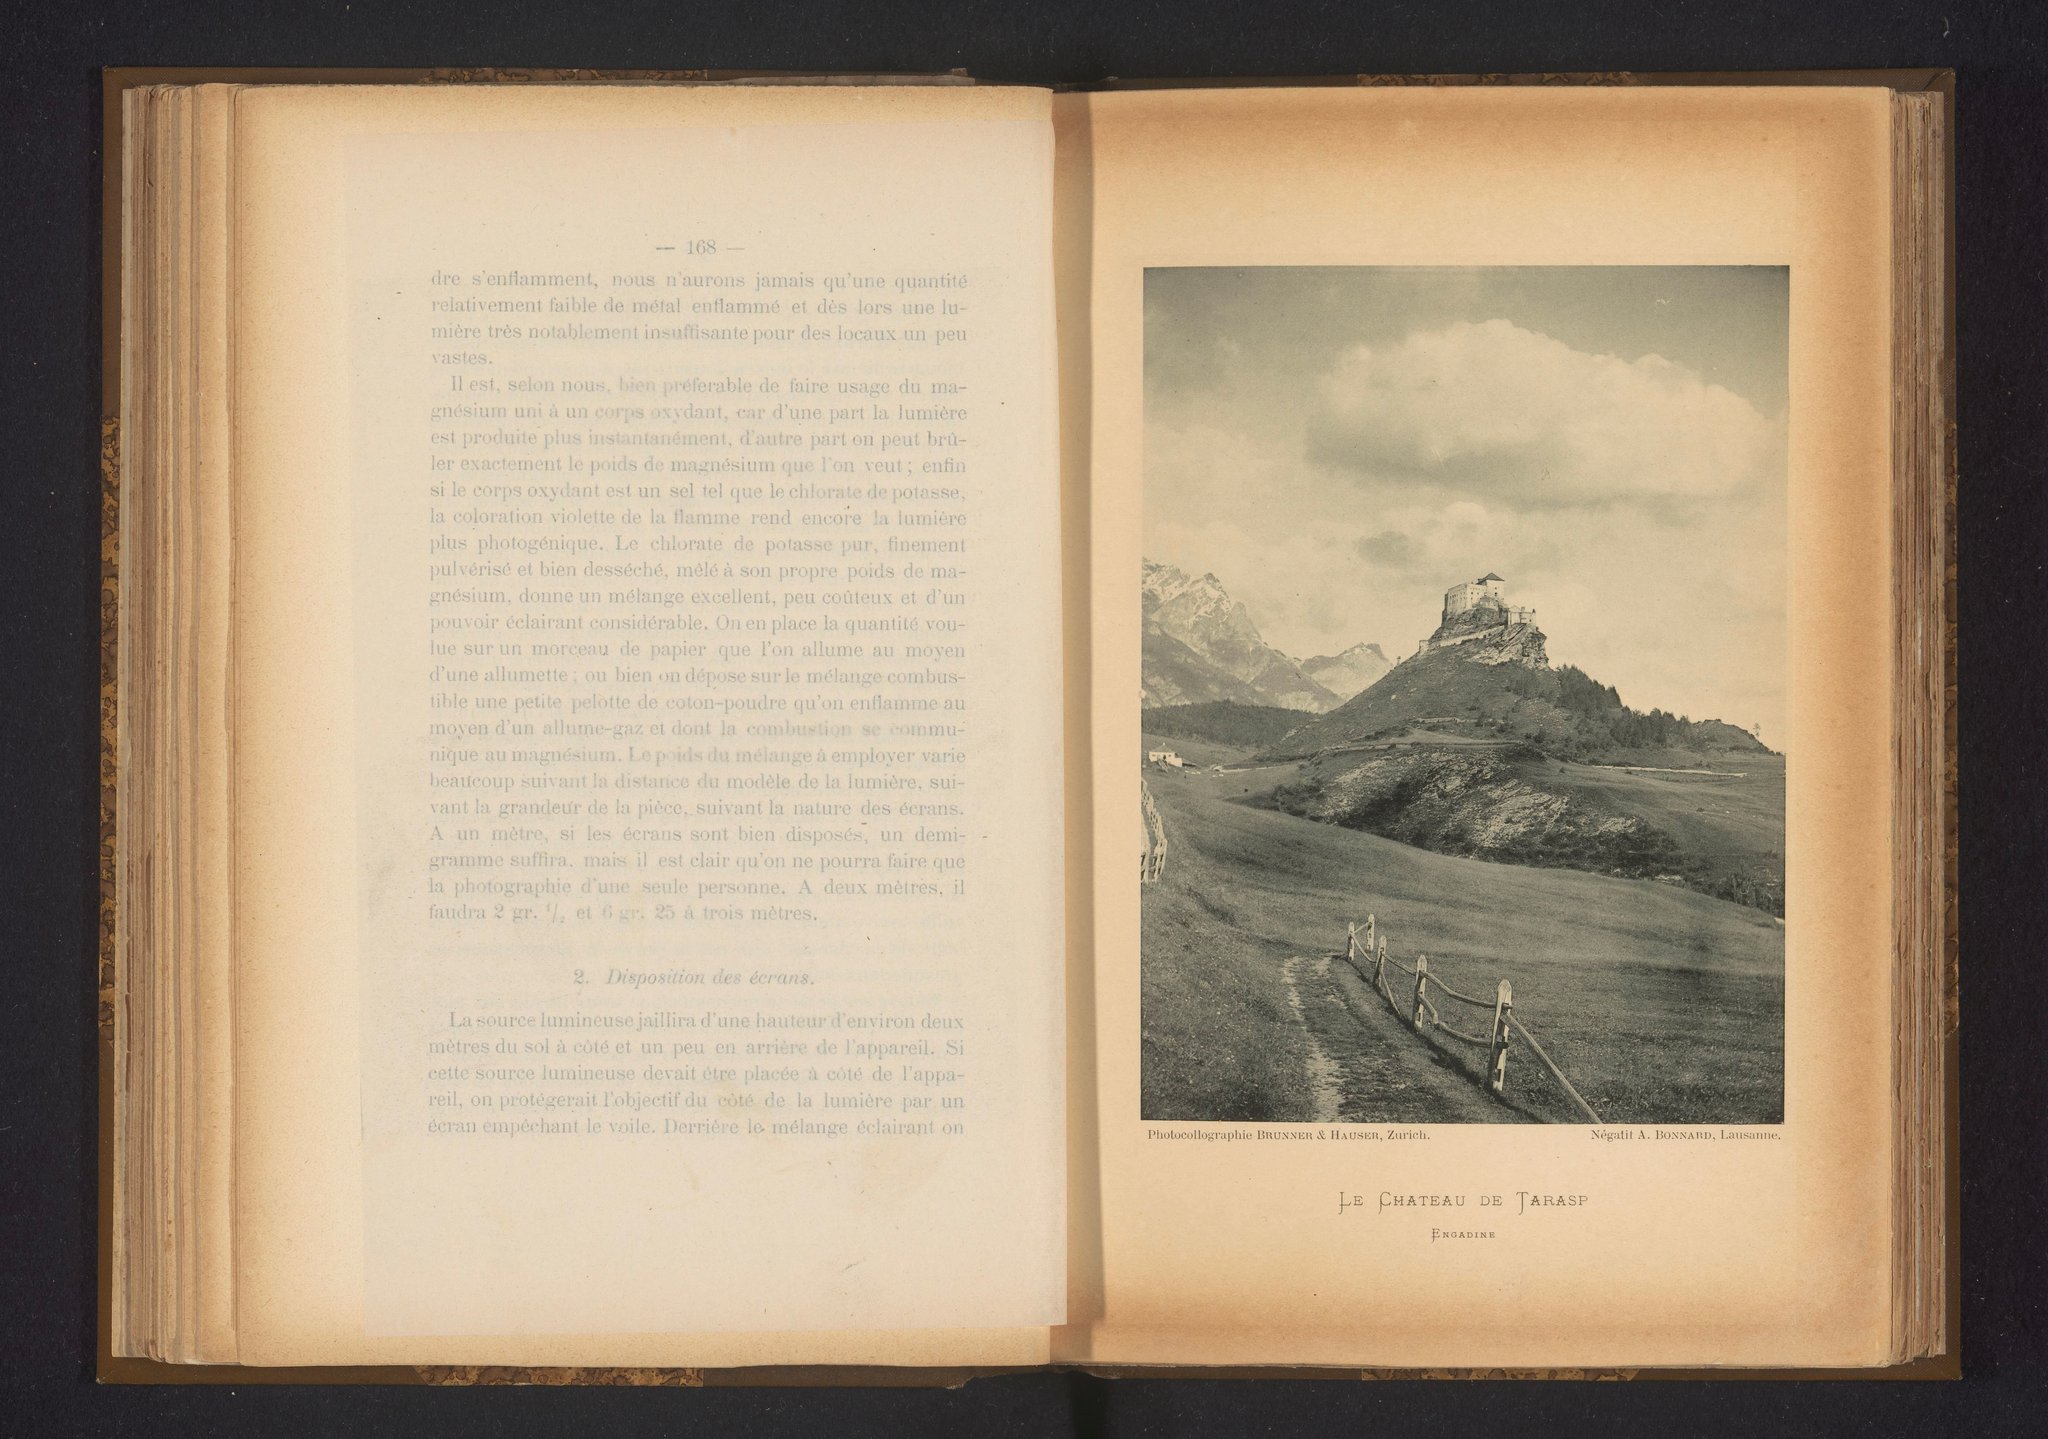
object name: photomechanical print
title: Gezicht op een kasteel in Tarasp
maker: a. bonnard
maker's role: fotograaf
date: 1887-1892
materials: paper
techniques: photograph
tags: (high) hill, landscape with tower or castle